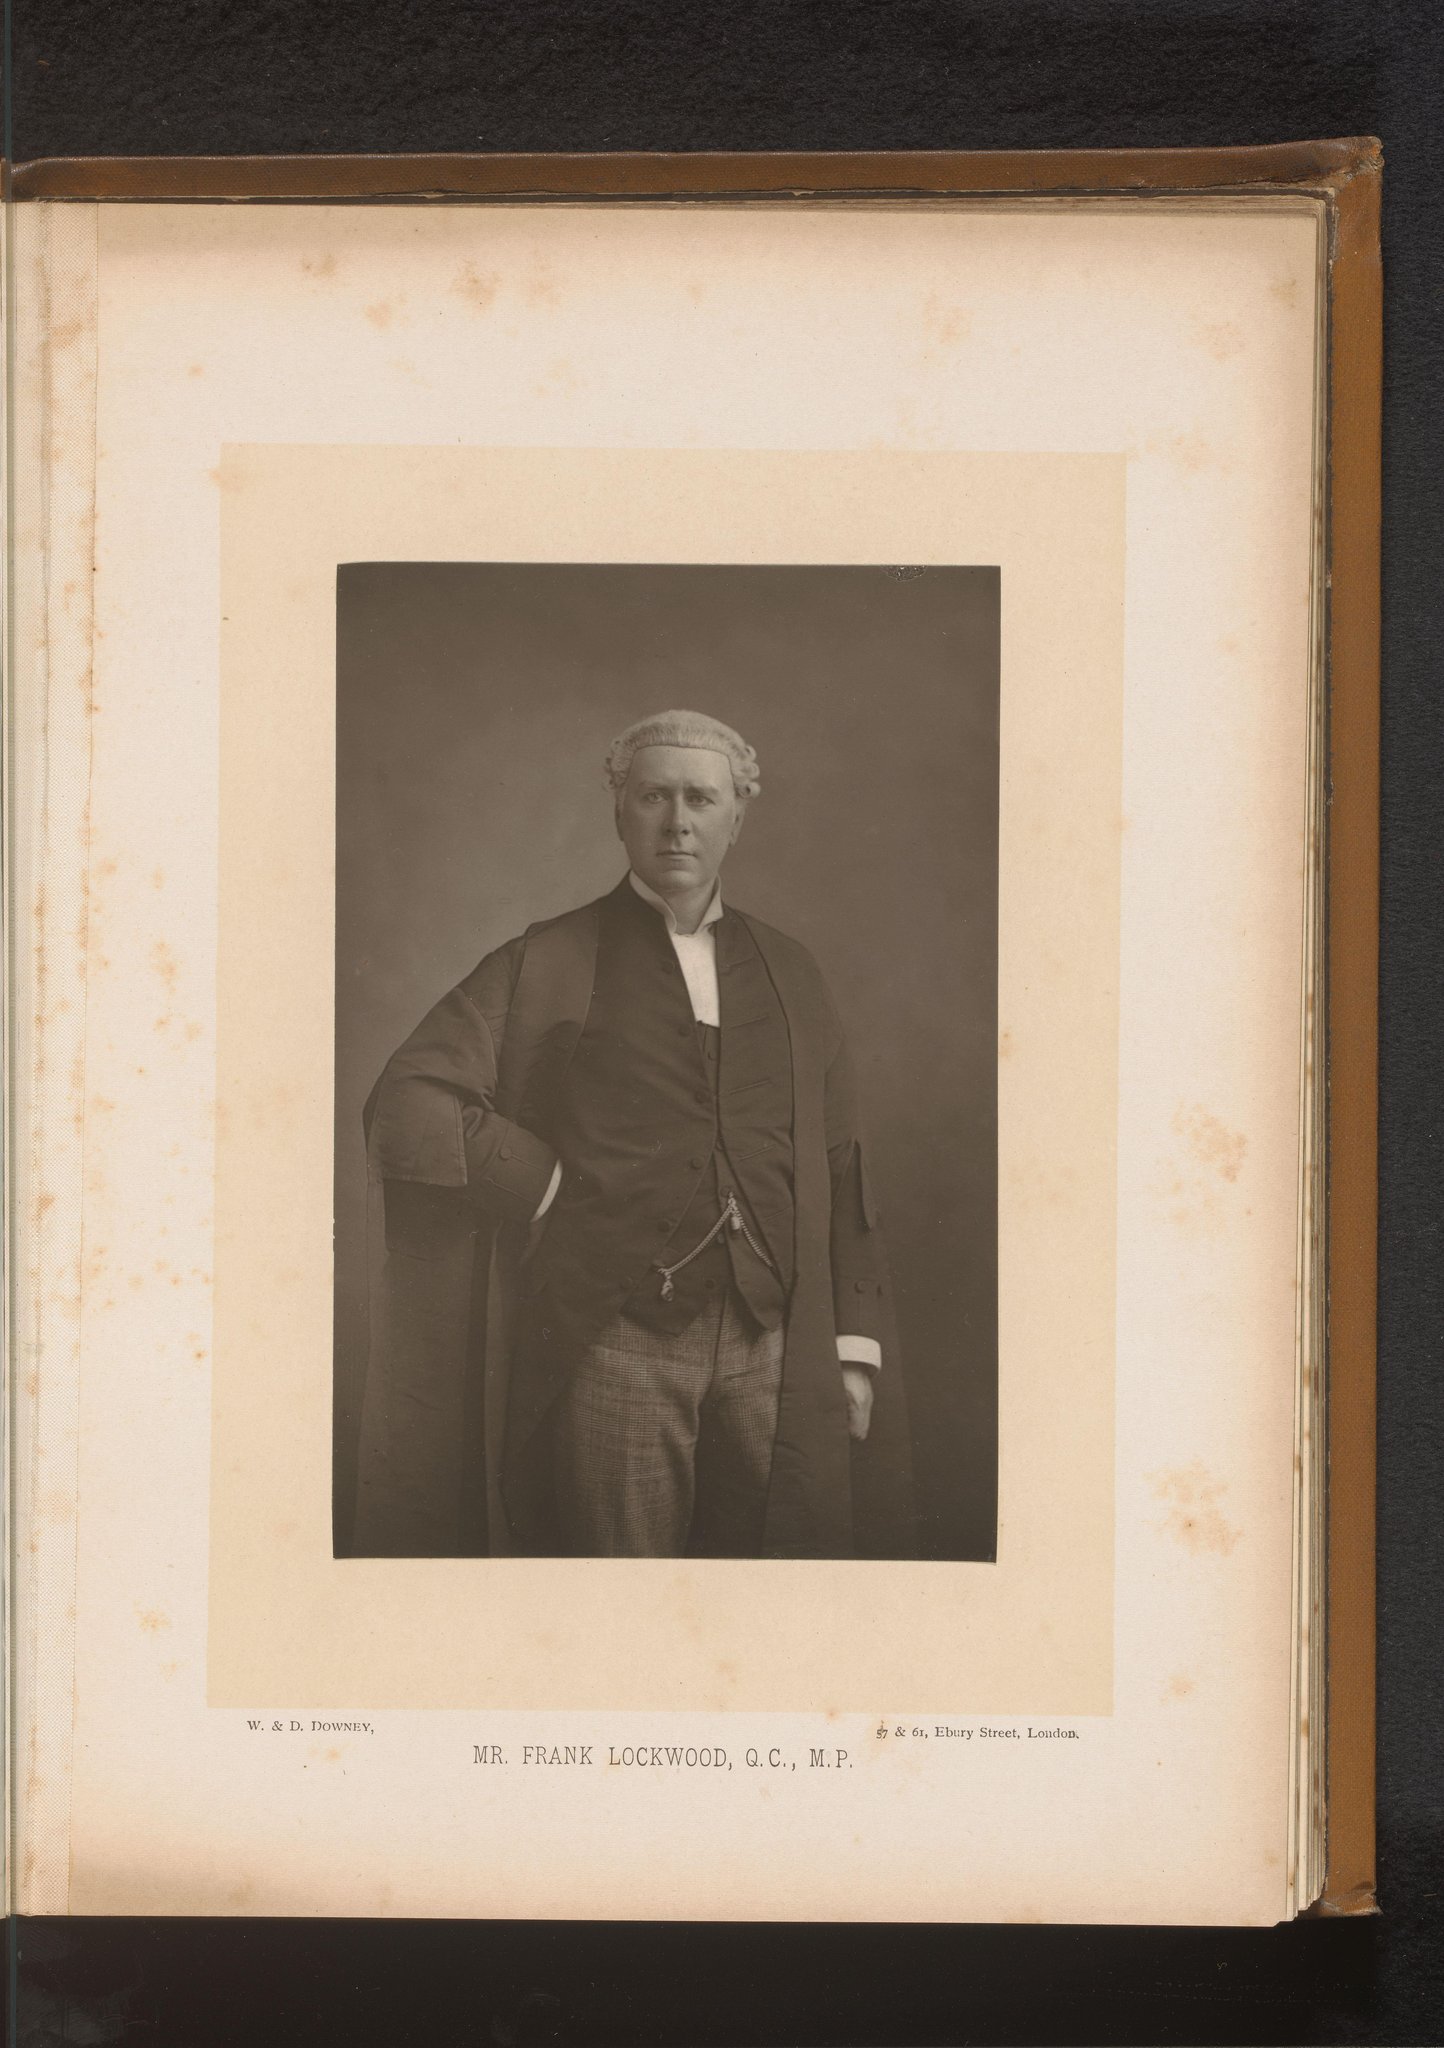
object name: page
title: Mr. Frank Lockwood, Q.C., M.P.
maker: Anonymous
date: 1880-1890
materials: paper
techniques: woodburytype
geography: london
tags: politician, e.g. party leader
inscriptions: inscription: ‘57 & 61, Elbury Street, London.’